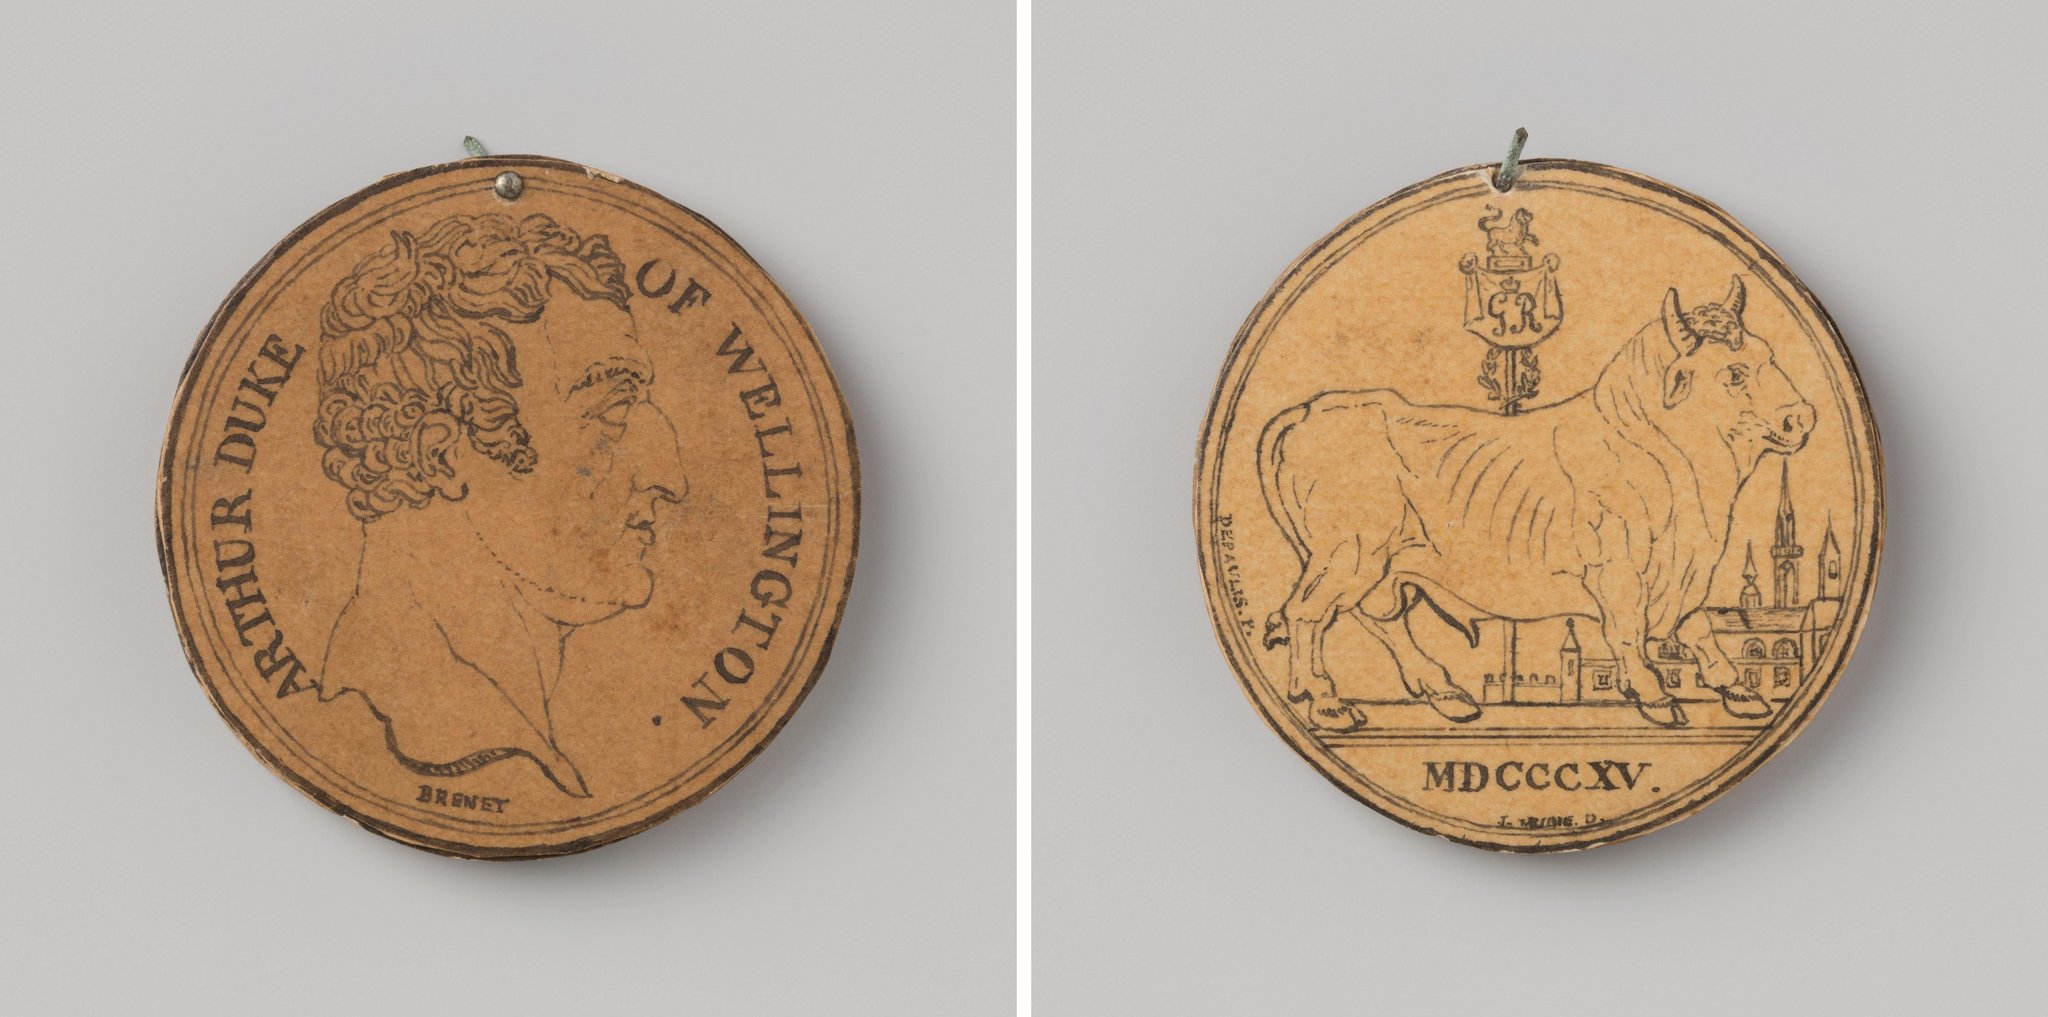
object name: medal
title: Slag bij Waterloo, ter ere van de hertog van Wellington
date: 1815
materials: cardboard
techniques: drawing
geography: england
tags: walmer castle, arthur wellesley of wellington, waterloo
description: Voorzijde: borststuk man binnen omschrift. Keerzijde: opschrift onder twee ineengeslagen handen binnen krans omwonden met lint met opschrift